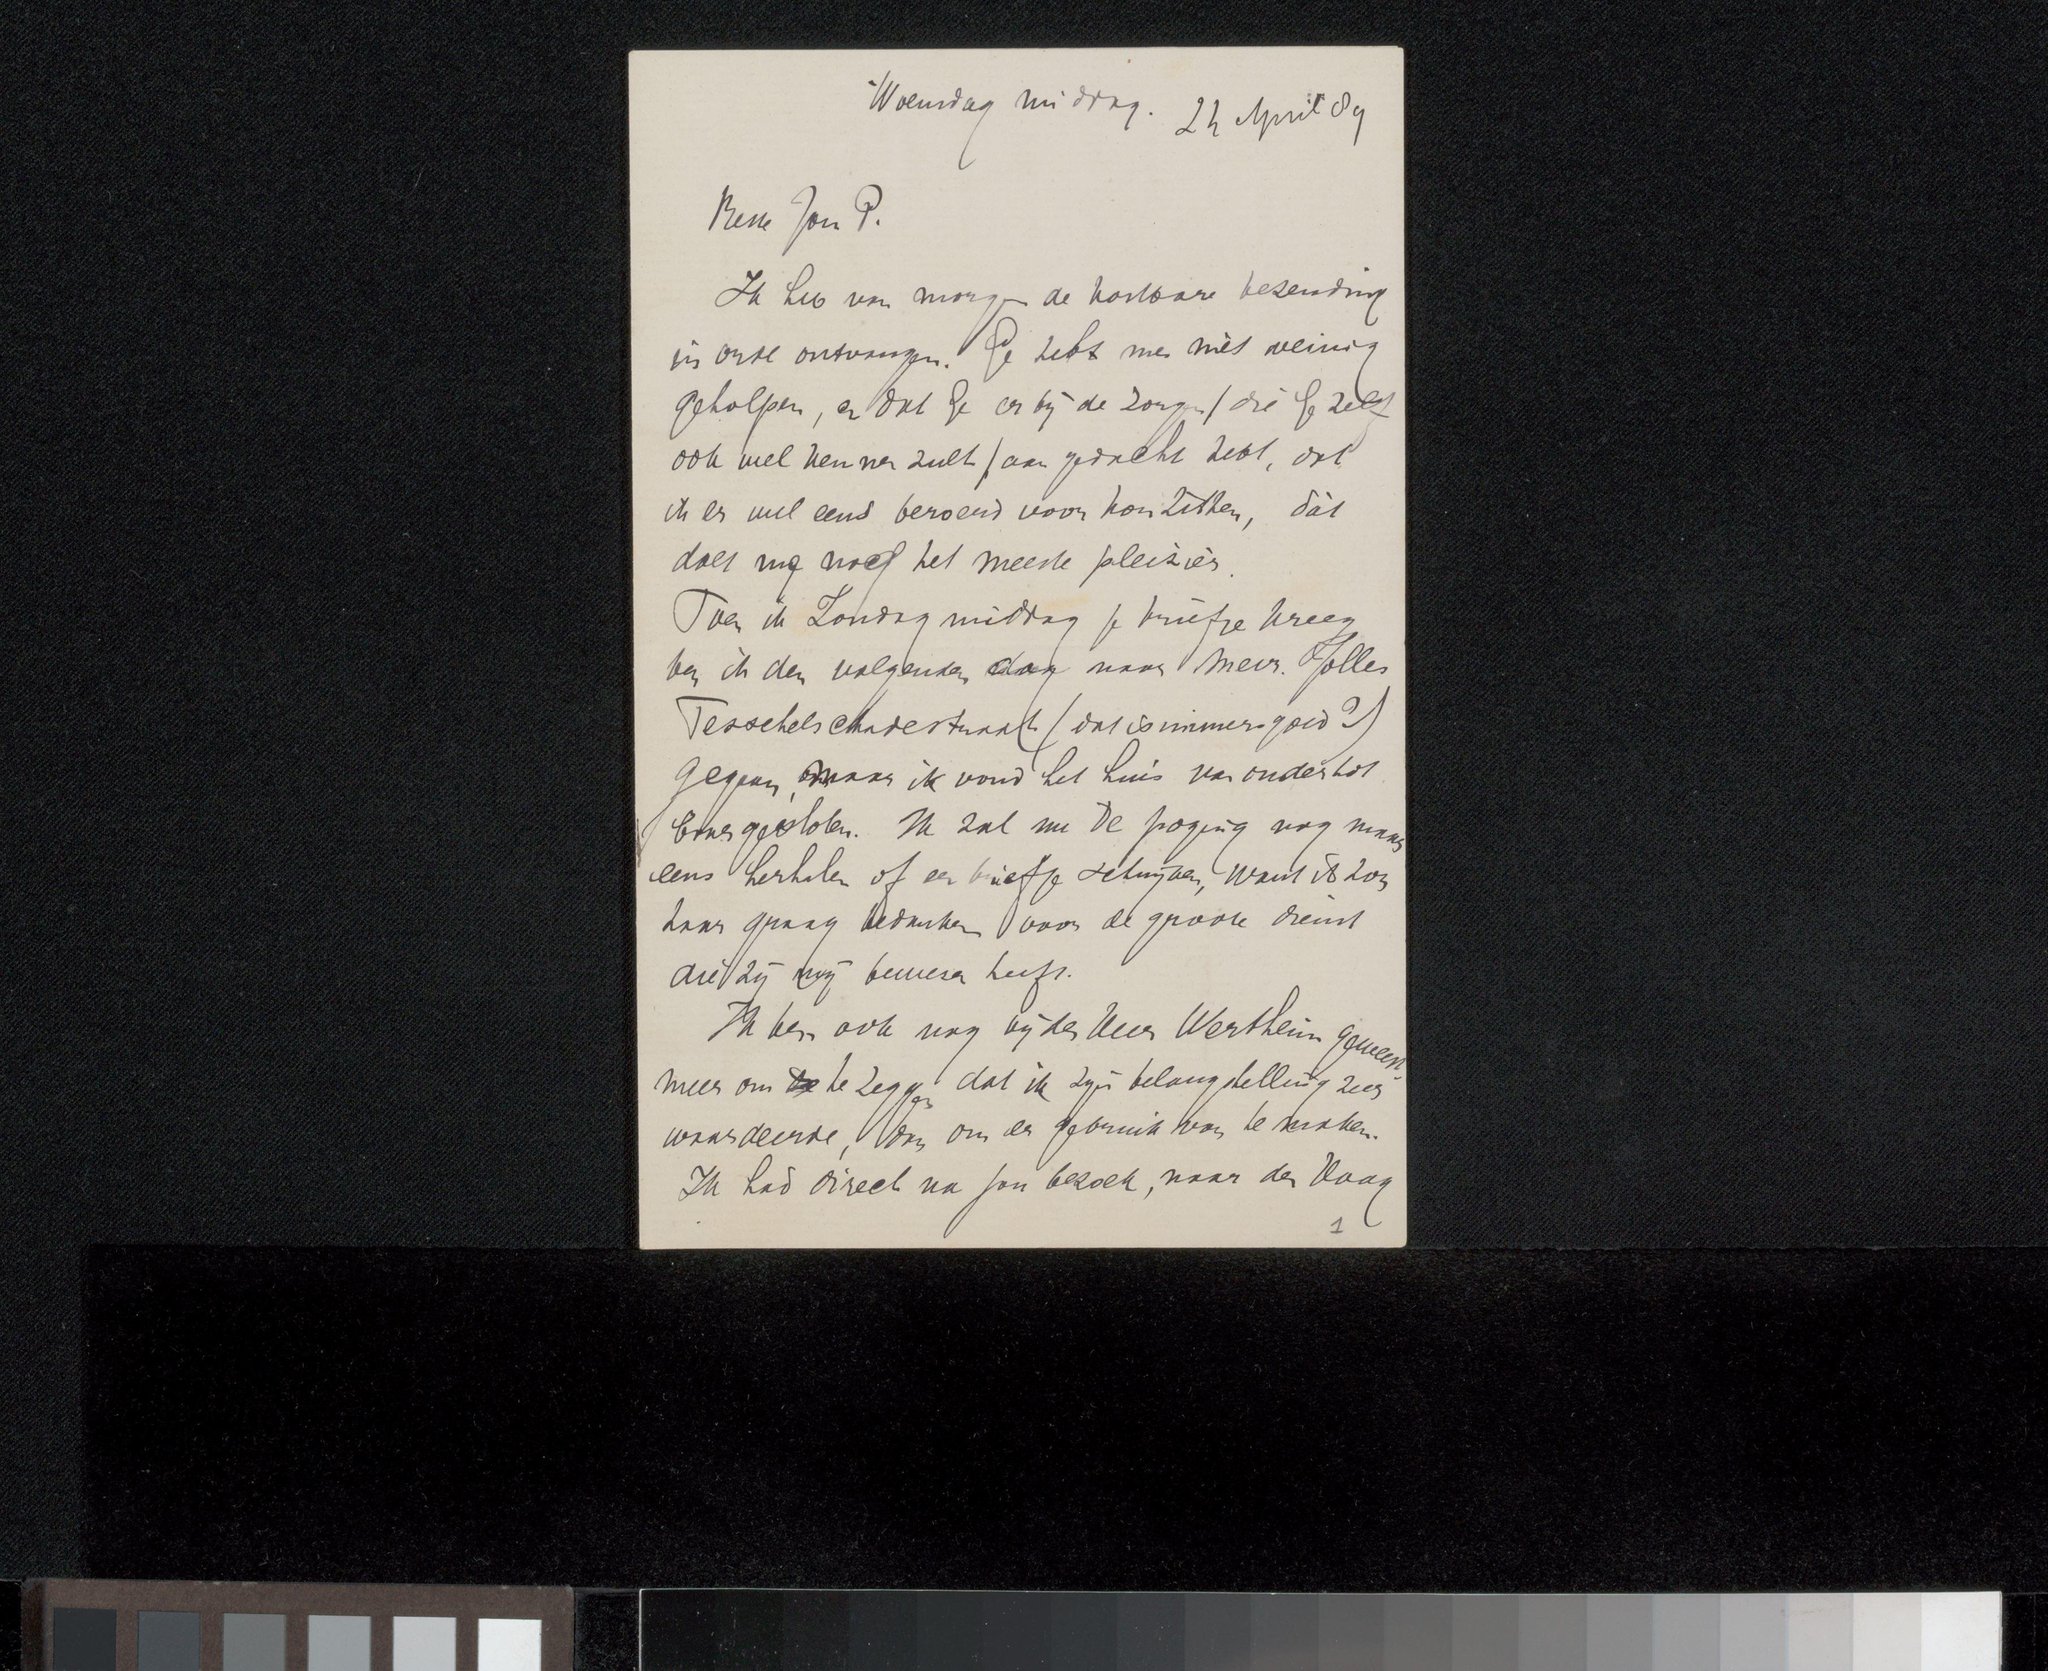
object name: letter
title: Brief aan Jan Veth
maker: antoon derkinderen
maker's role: draughtsman, painter, print maker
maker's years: 1859-1925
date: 1889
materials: ink, paper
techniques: pen, writing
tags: jan veth, pierre joseph hubert cuypers, politician, dordrecht, jacoba cornelia jolles-singels, painting (including book-illumination, miniature-painting), money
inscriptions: collector's mark: ‘RPK’